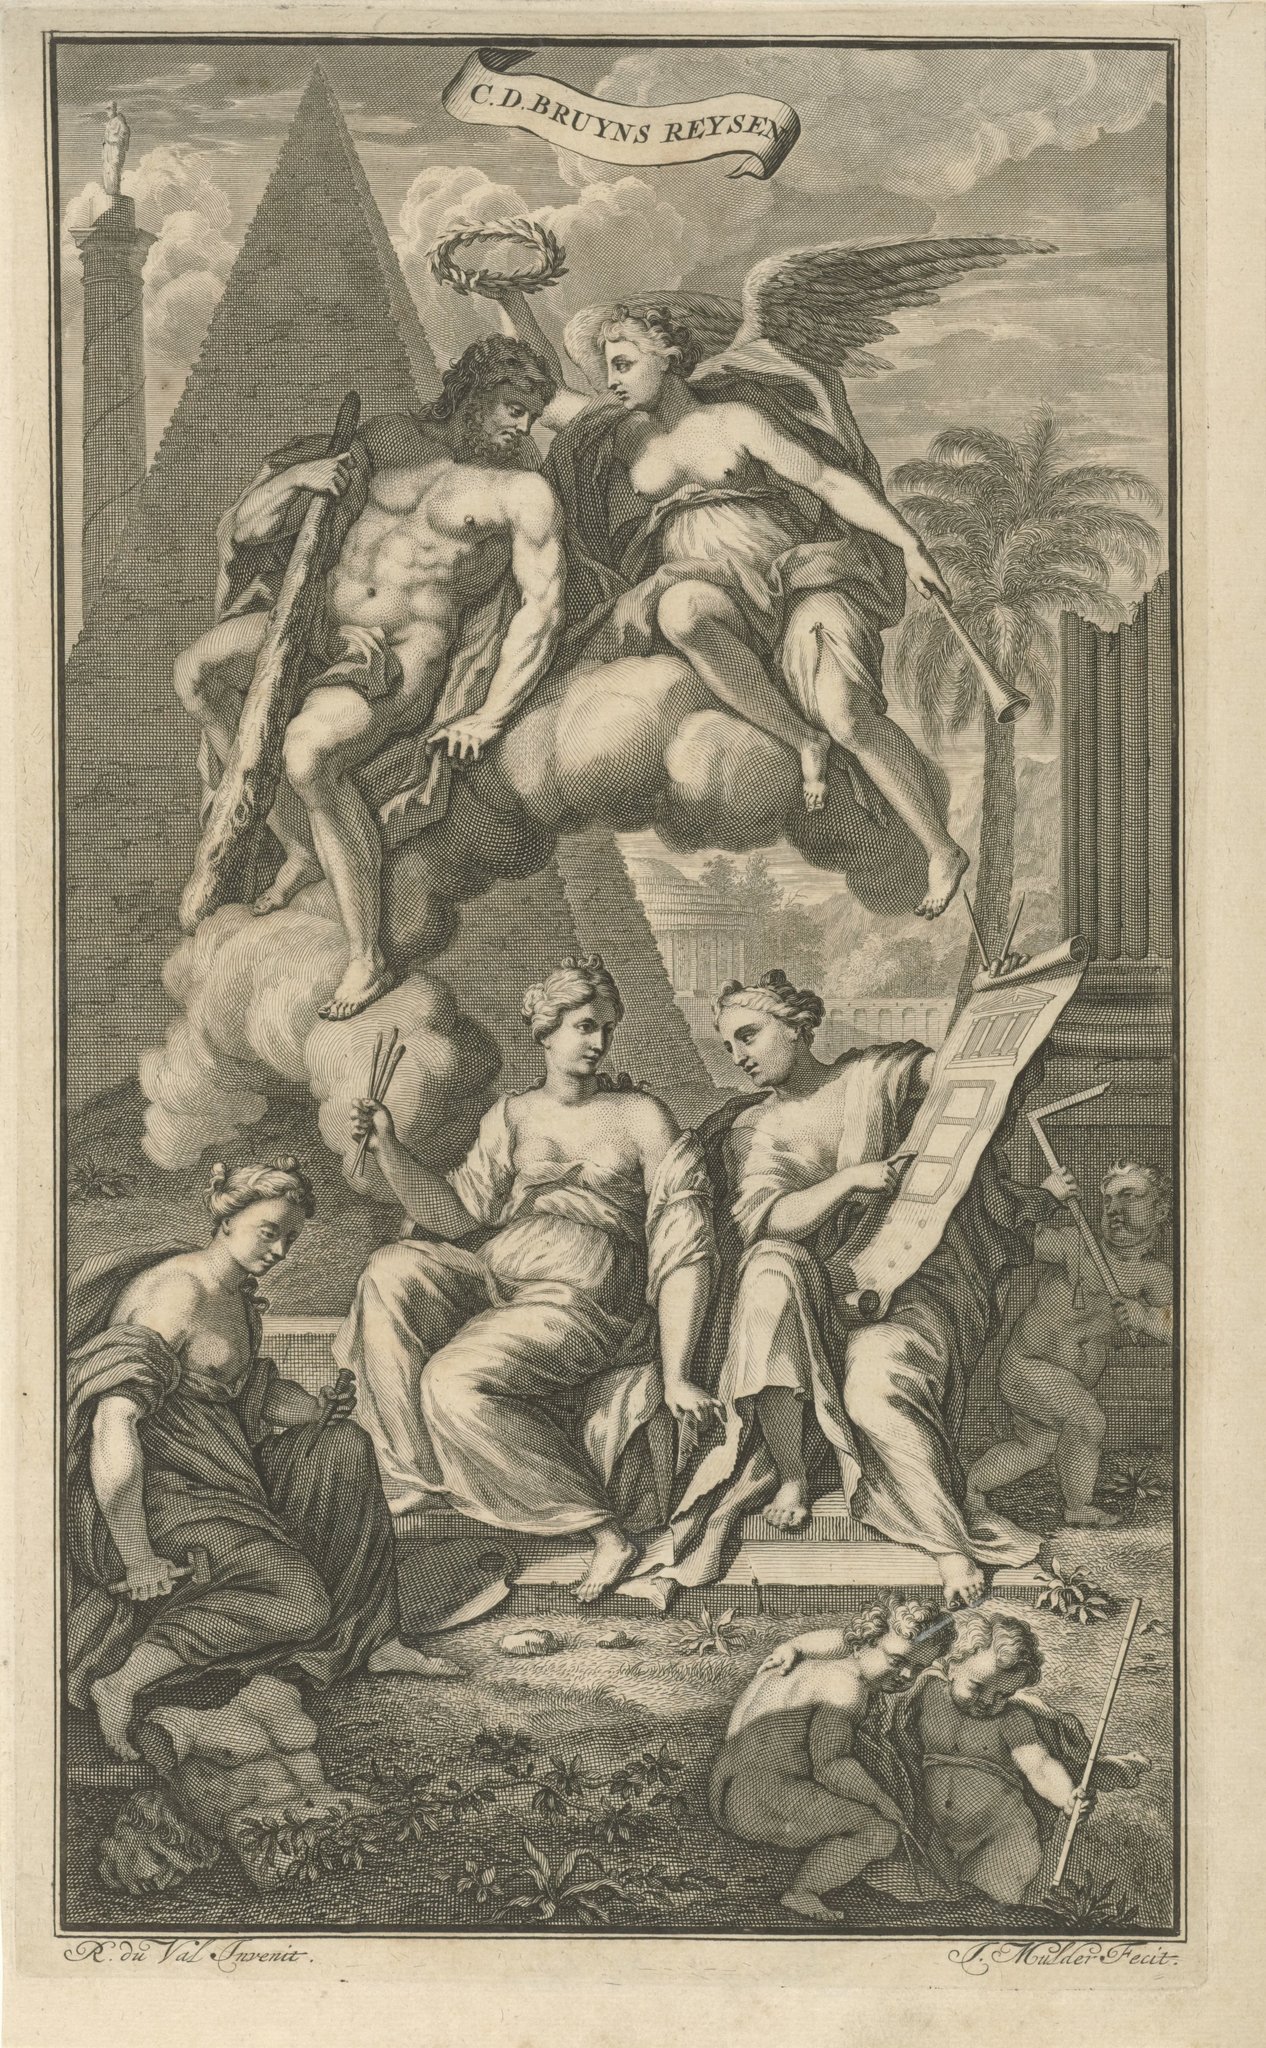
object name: print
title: Titelpagina voor: Cornelis de Bruyn, Reizen van Cornelis de Bruyn, door de vermaardste deelen van Klein Asia, 1698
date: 1698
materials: paper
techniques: engraving, etching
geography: delft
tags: (story of) hercules (heracles), 'pictura', symbolic representations, allegories and emblems ~ painting; 'pittura' (ripa), 'sculptura', symbolic representations, allegories and emblems ~ sculpture; 'scoltura' (ripa), victoria as roman personification, 'architectura', symbolic representations, allegories and emblems ~ architecture; 'architettura' (ripa), cupids: 'amores', 'amoretti', 'putti'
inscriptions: collector's mark: Lugt 2228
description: Hercules, met een knots in zijn hand, wordt gekroond door de gevleugelde Victoria. Op de grond zitten de personificaties van sculptuur, schilderkunst en architectuur bijeen. Putti spelen met de meetinstrumenten van Architectuur. Op de achtergrond een piramide, klassieke gebouwen en een palmboom.